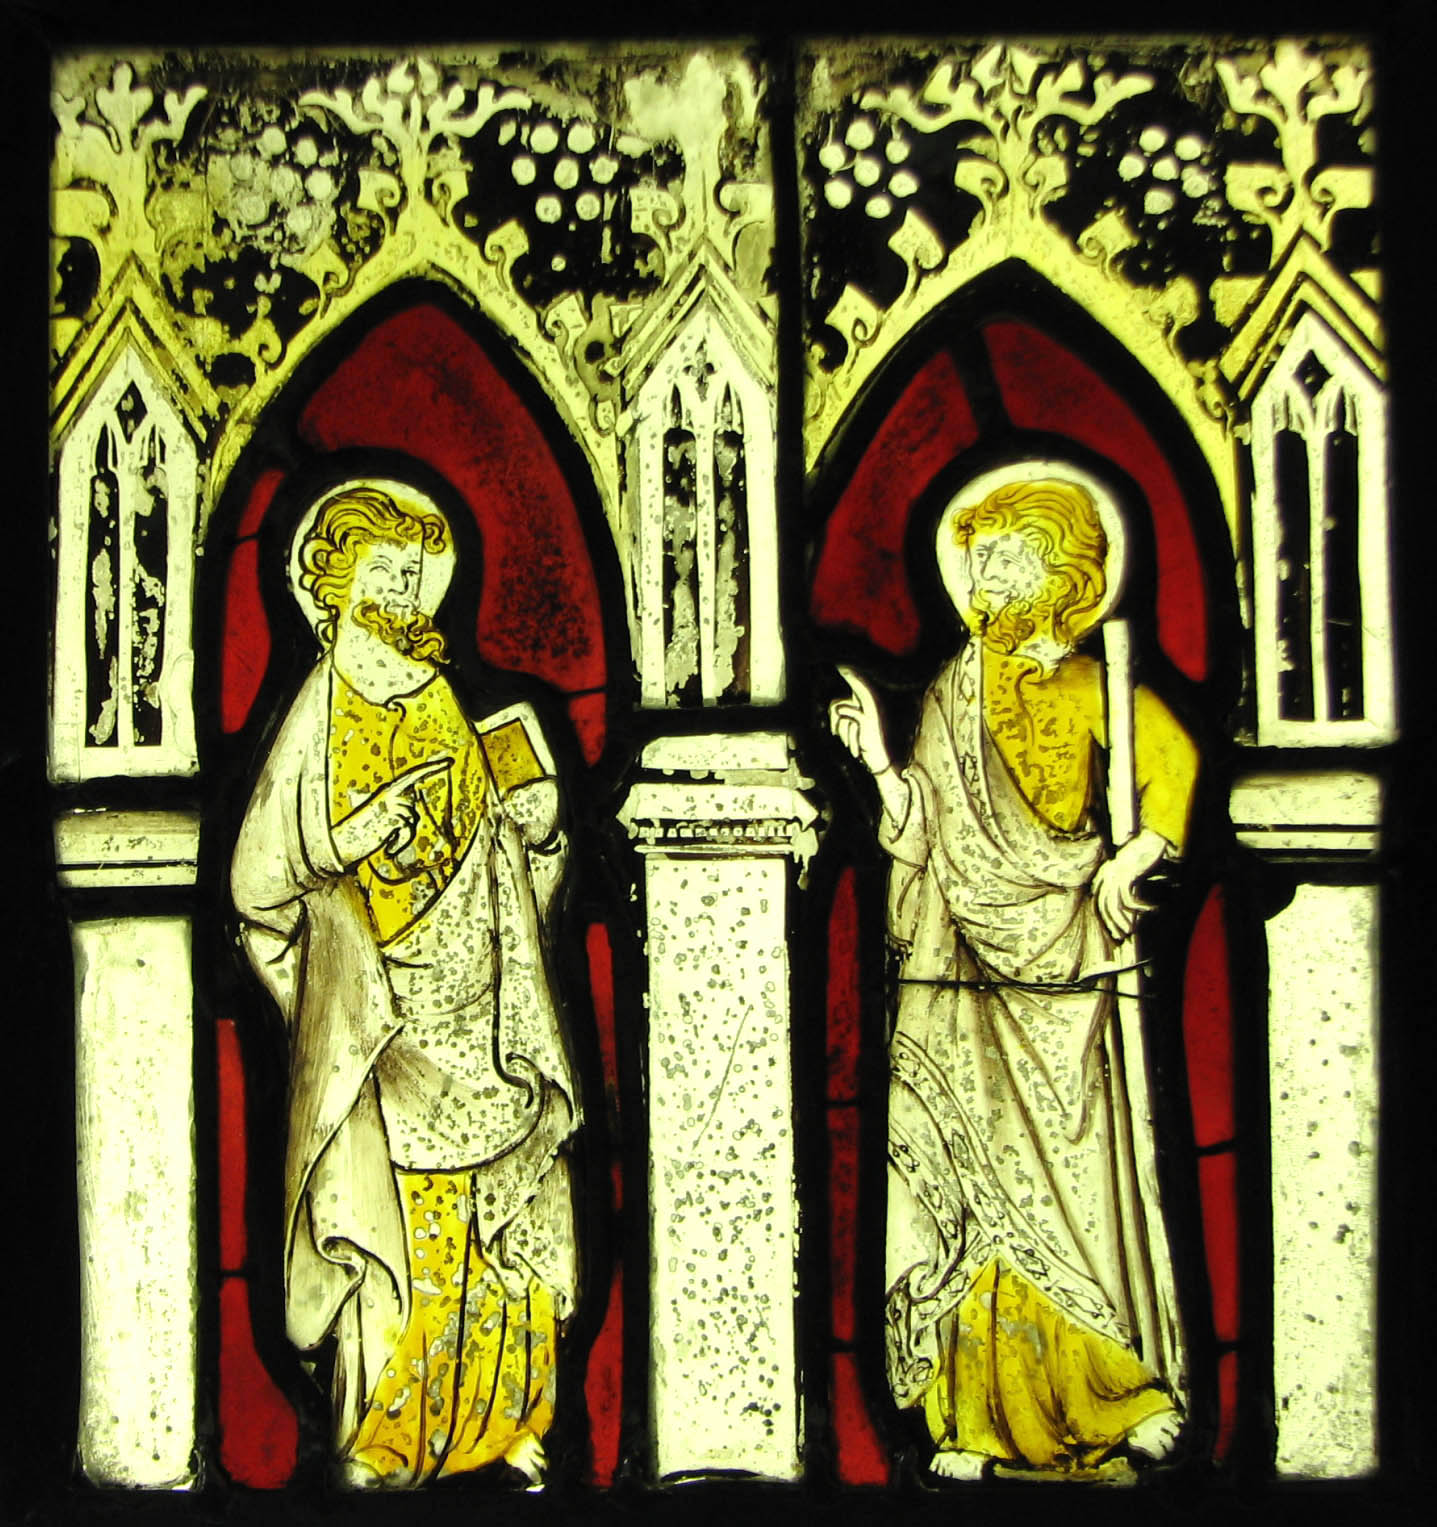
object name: panel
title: Two Apostles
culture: french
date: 1320-1335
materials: glass, metal, pigment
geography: france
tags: apostles